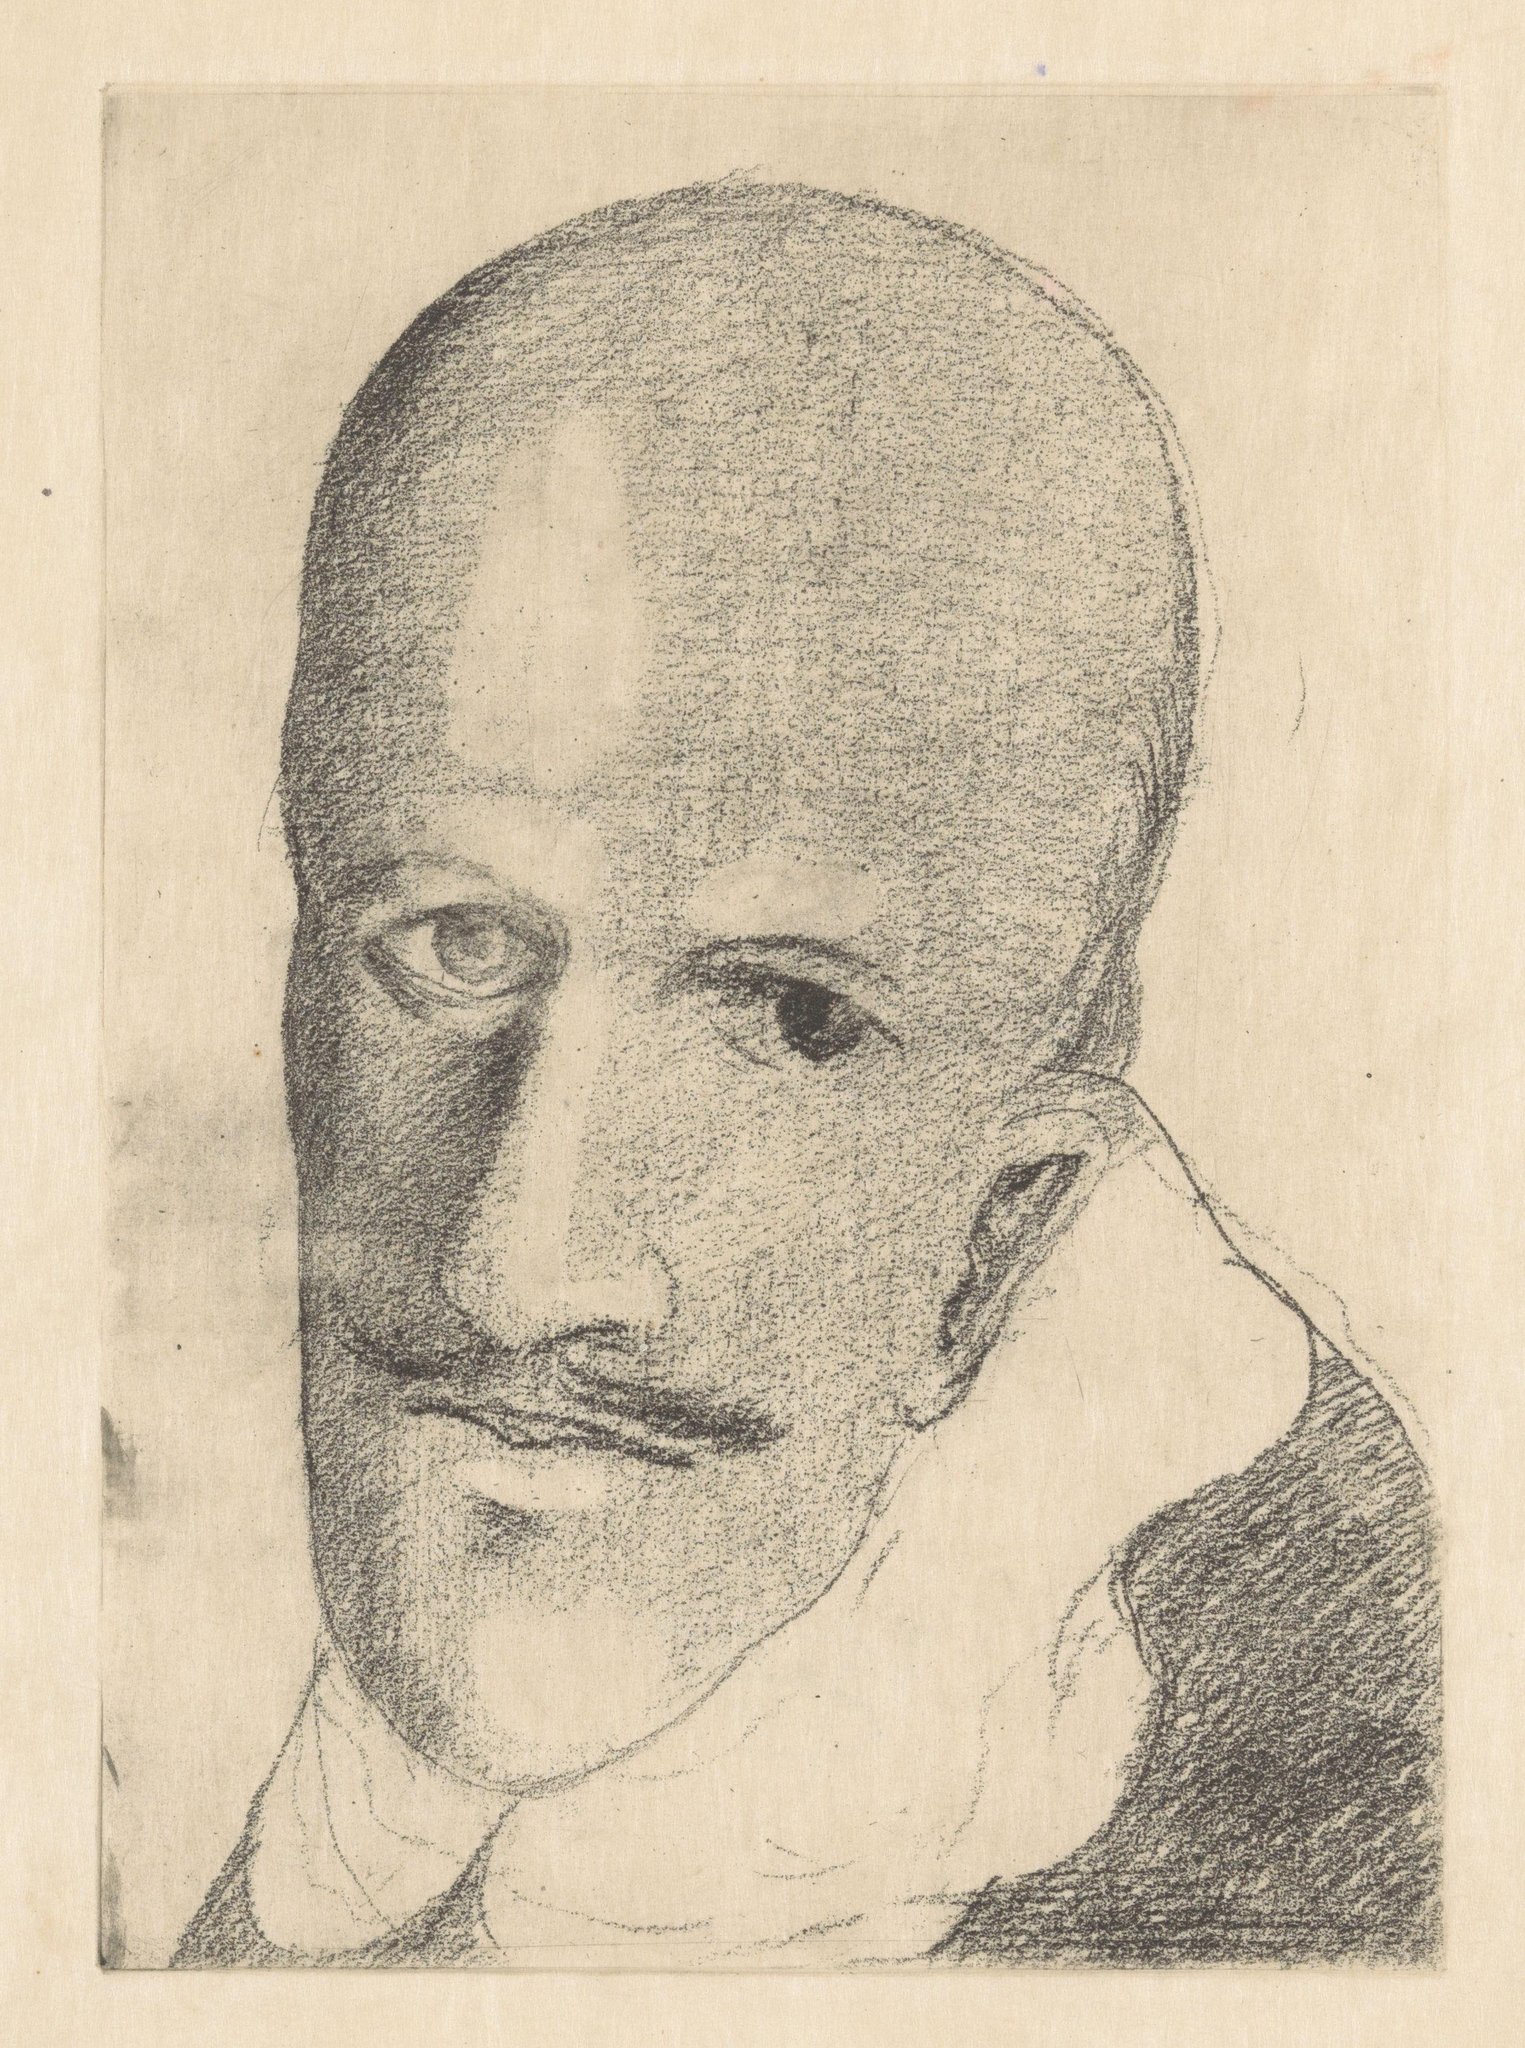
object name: print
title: Kale man met hoog voorhoofd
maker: marius holleman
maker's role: draughtsman, print maker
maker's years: 1878-1926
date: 1904-1926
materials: paper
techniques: etching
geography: groningen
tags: morphology of facial expression ~ forehead, baldness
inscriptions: collector's mark: Lugt 2228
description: De man heeft een snor en een witte kraag.